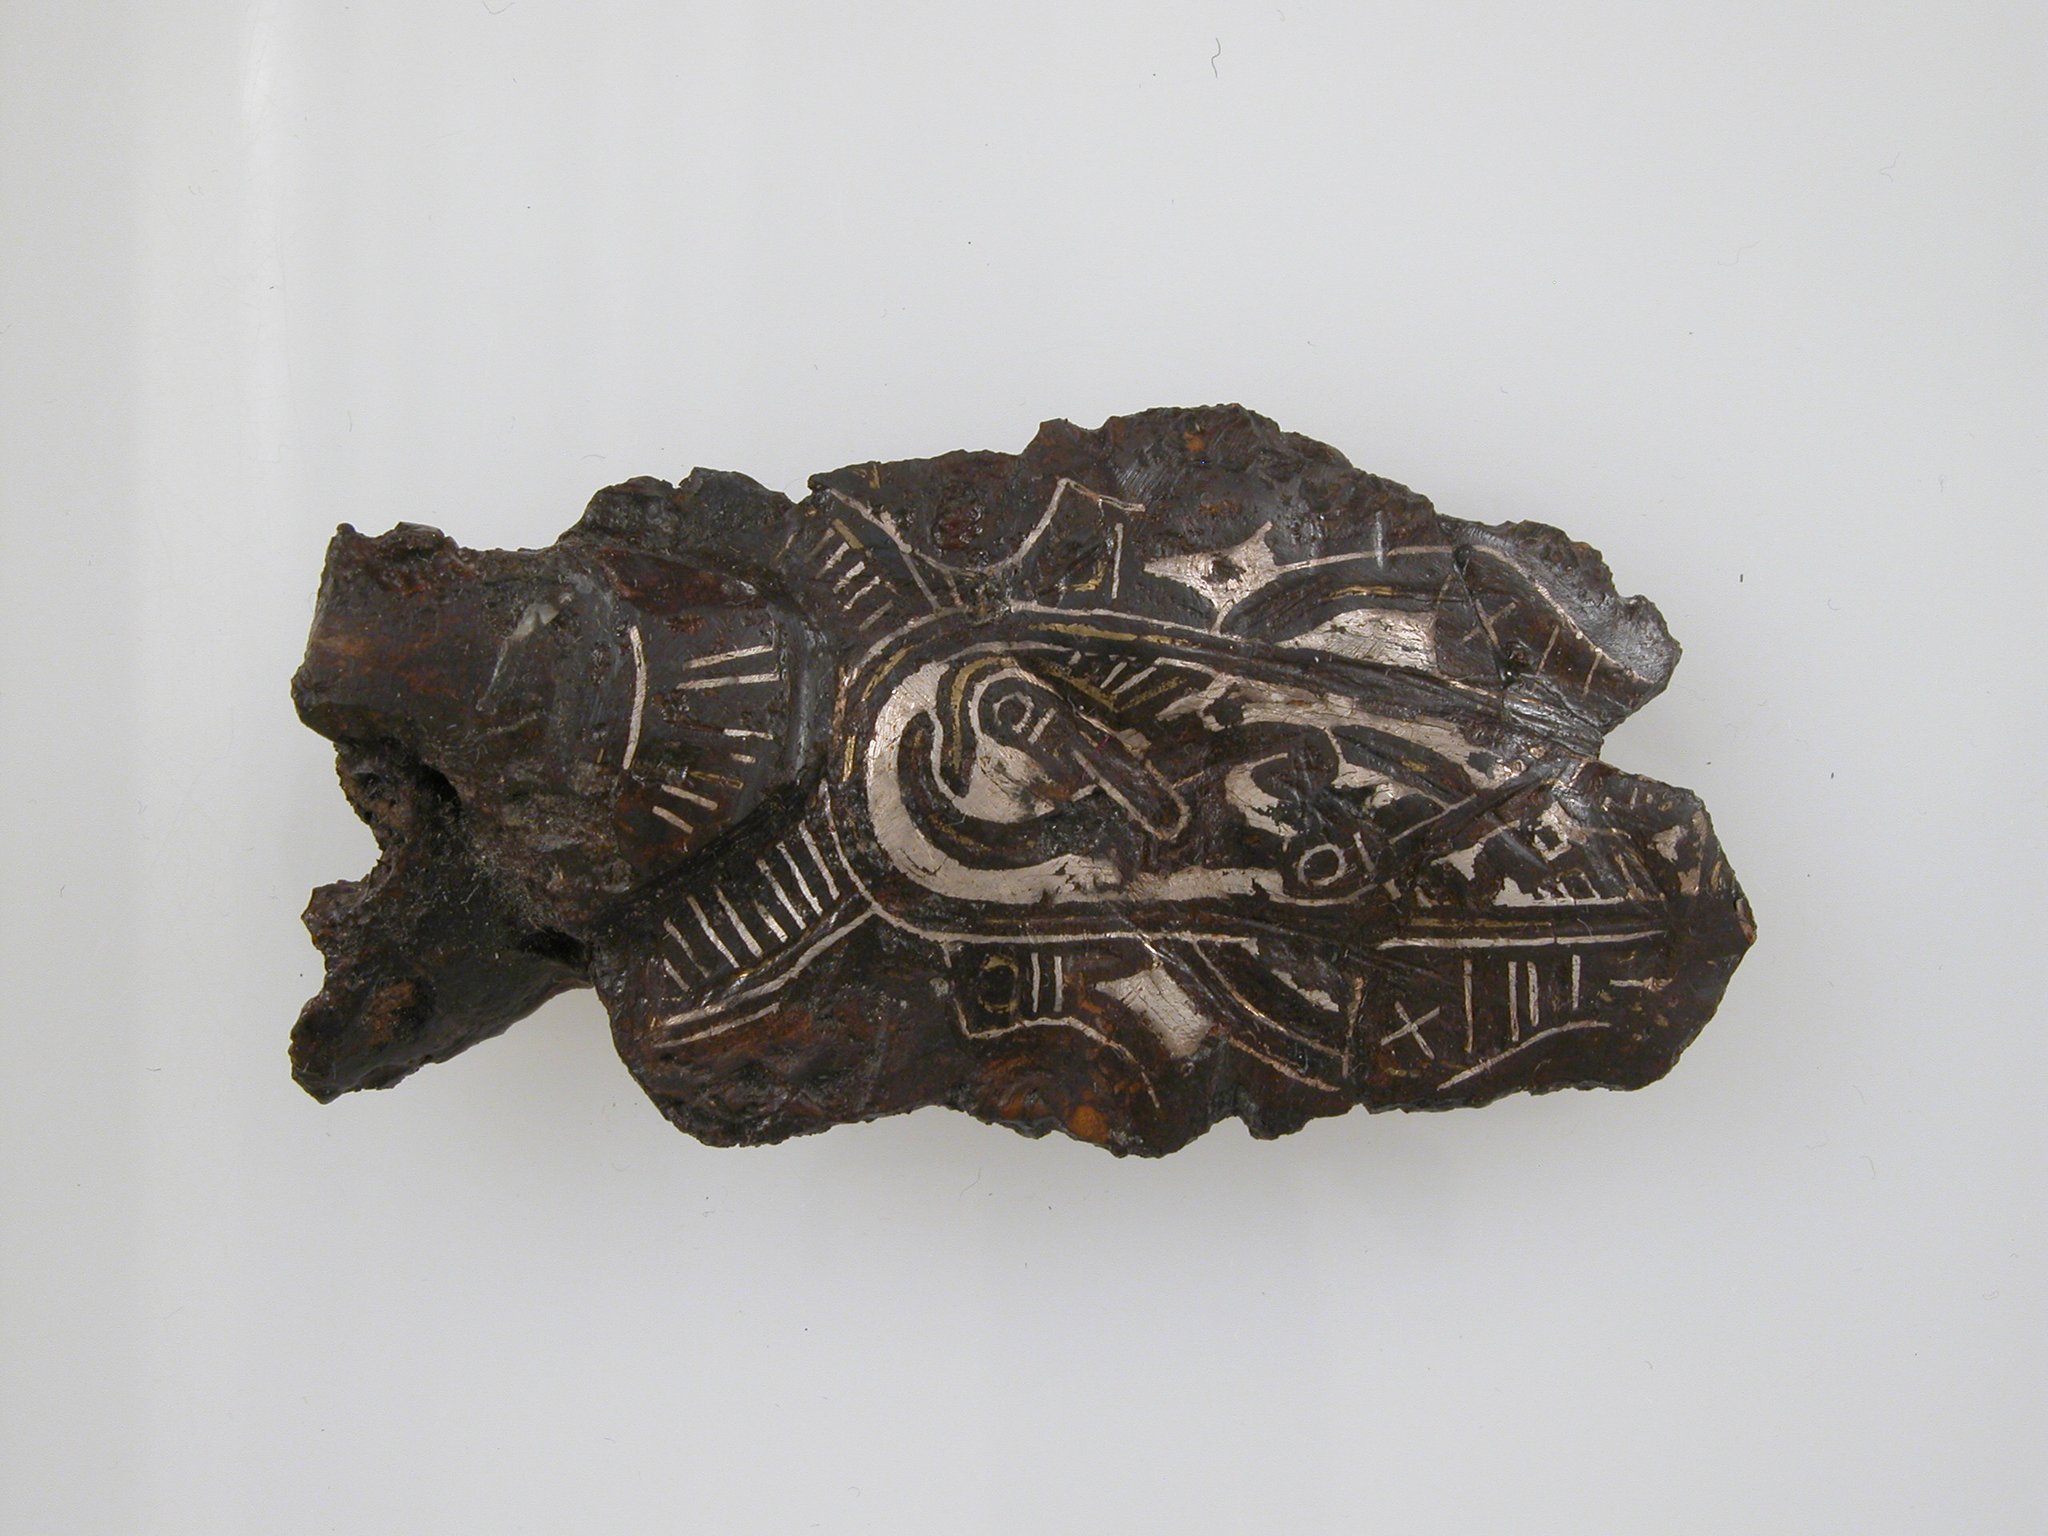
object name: belt buckle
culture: frankish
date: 601-700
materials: brass, iron, silver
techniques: inlay